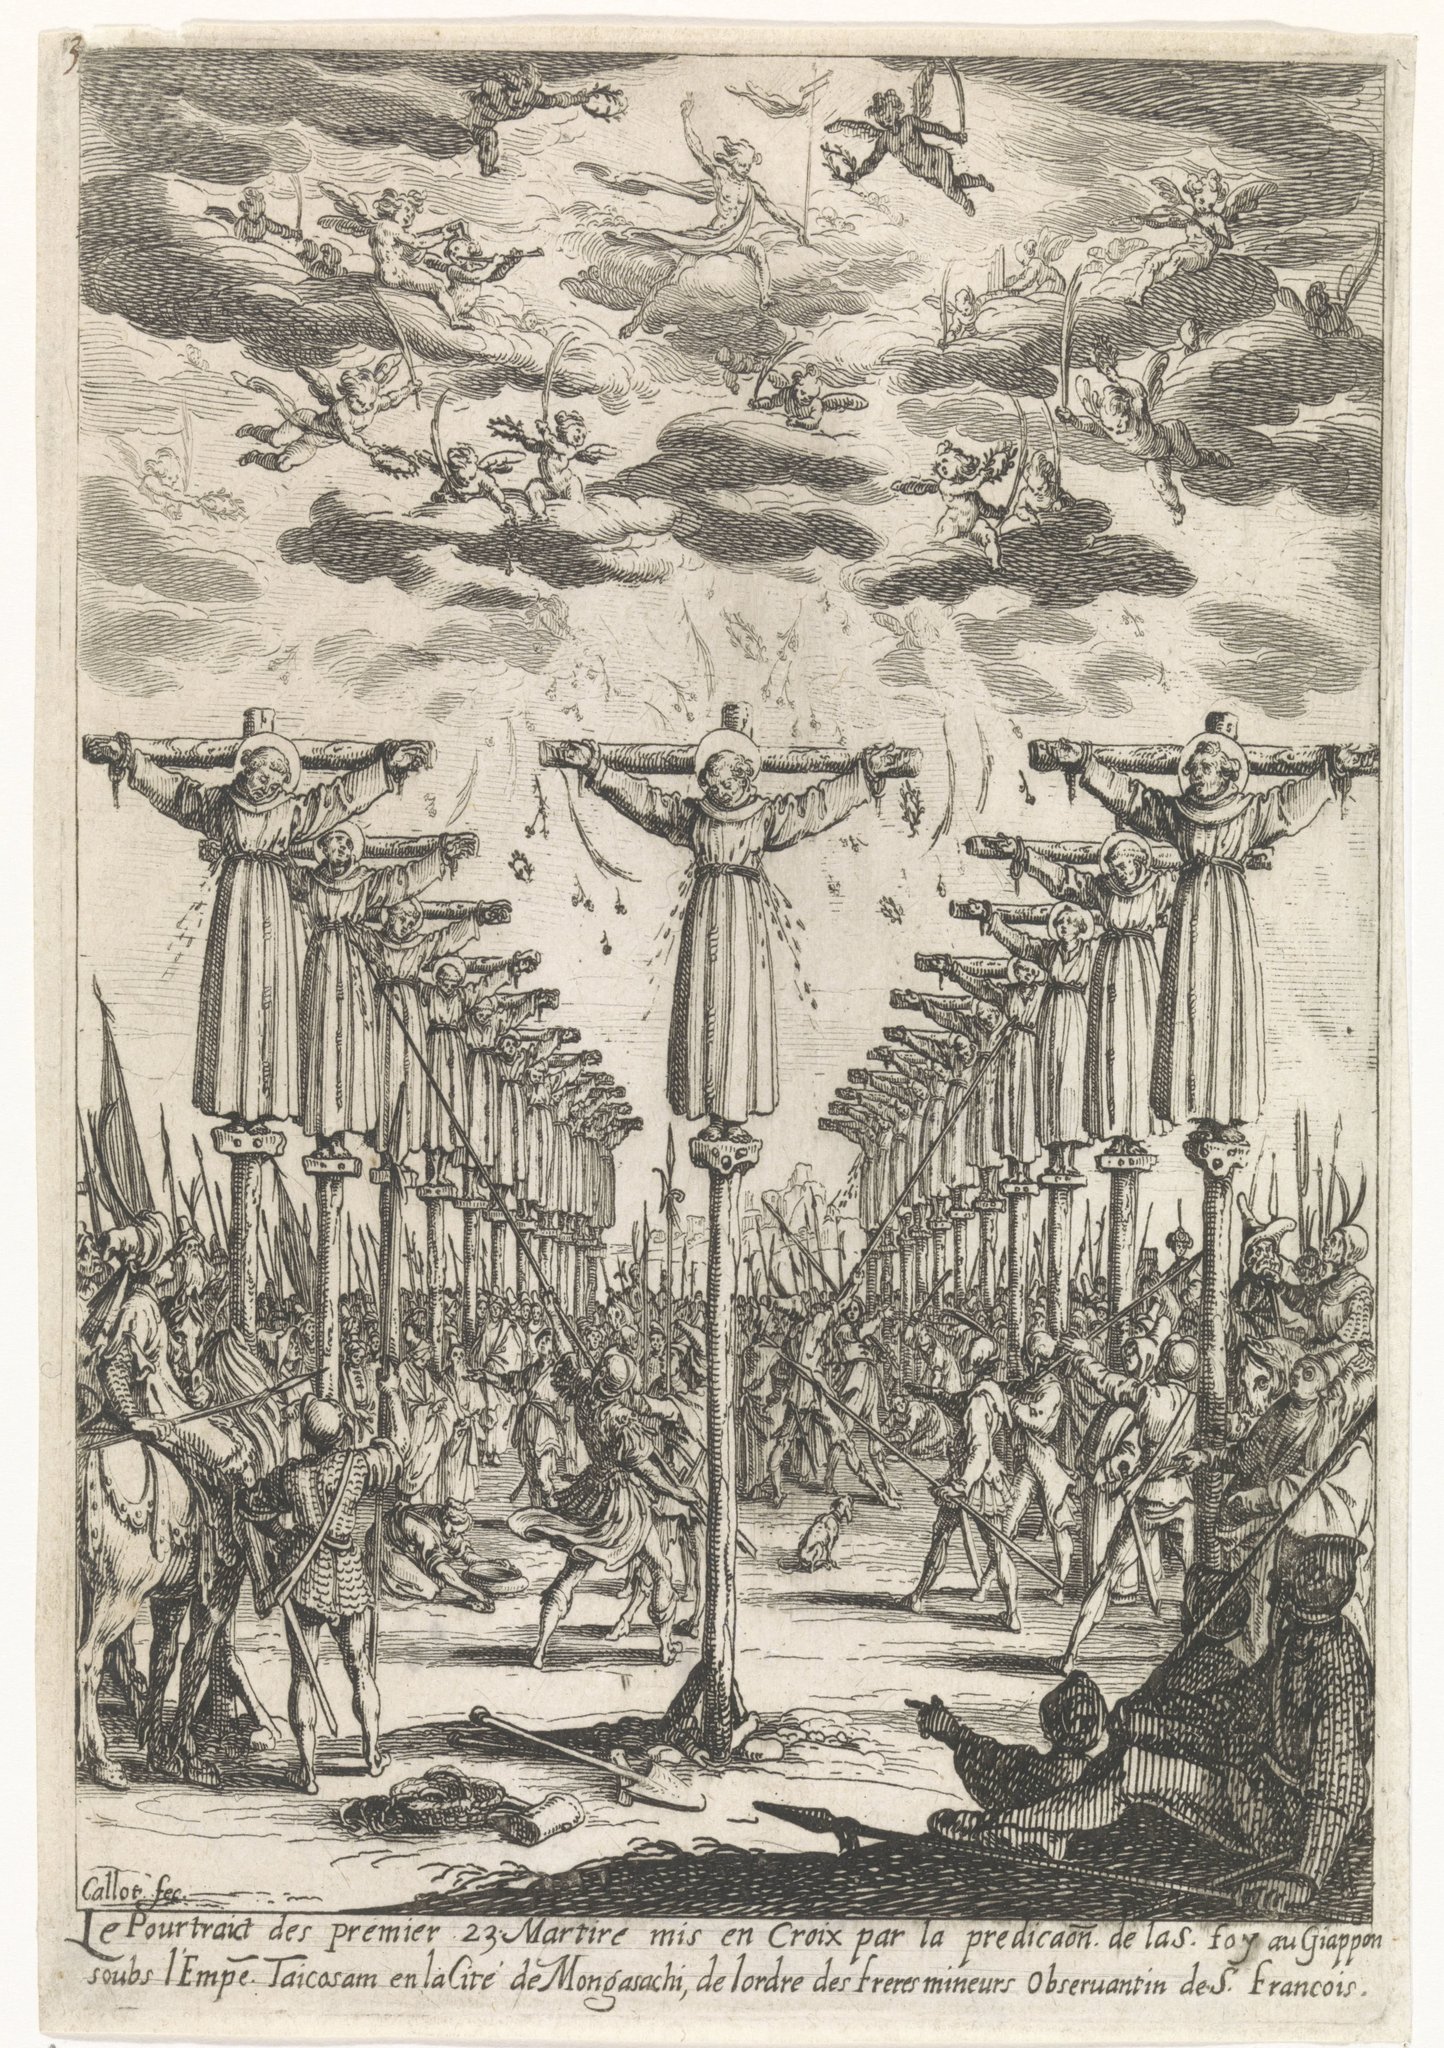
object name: print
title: Martelaren van Japan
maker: jacques callot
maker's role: draughtsman, print maker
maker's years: 1592-1635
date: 1627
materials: paper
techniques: etching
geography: nancy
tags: near nagasaki in japan, twenty-six franciscan and/or jesuit friars are crucified and pierced with lances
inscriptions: collector's mark: Lugt 2760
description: Kruisiging van 23 Franciscaner monniken in Japan. De kruisen staan in twee lange rijen opgesteld. Soldaten lopen ertussendoor en steken hier en daar een gekruisigde met hun lans. Aan de hemel verschijnen Johannes de Doper (Christus?) en een grote groep engelen. Zij werpen palmtakken en lauwerkransen naar de martelaren. Onder de voorstelling een onderschrift in het Frans.